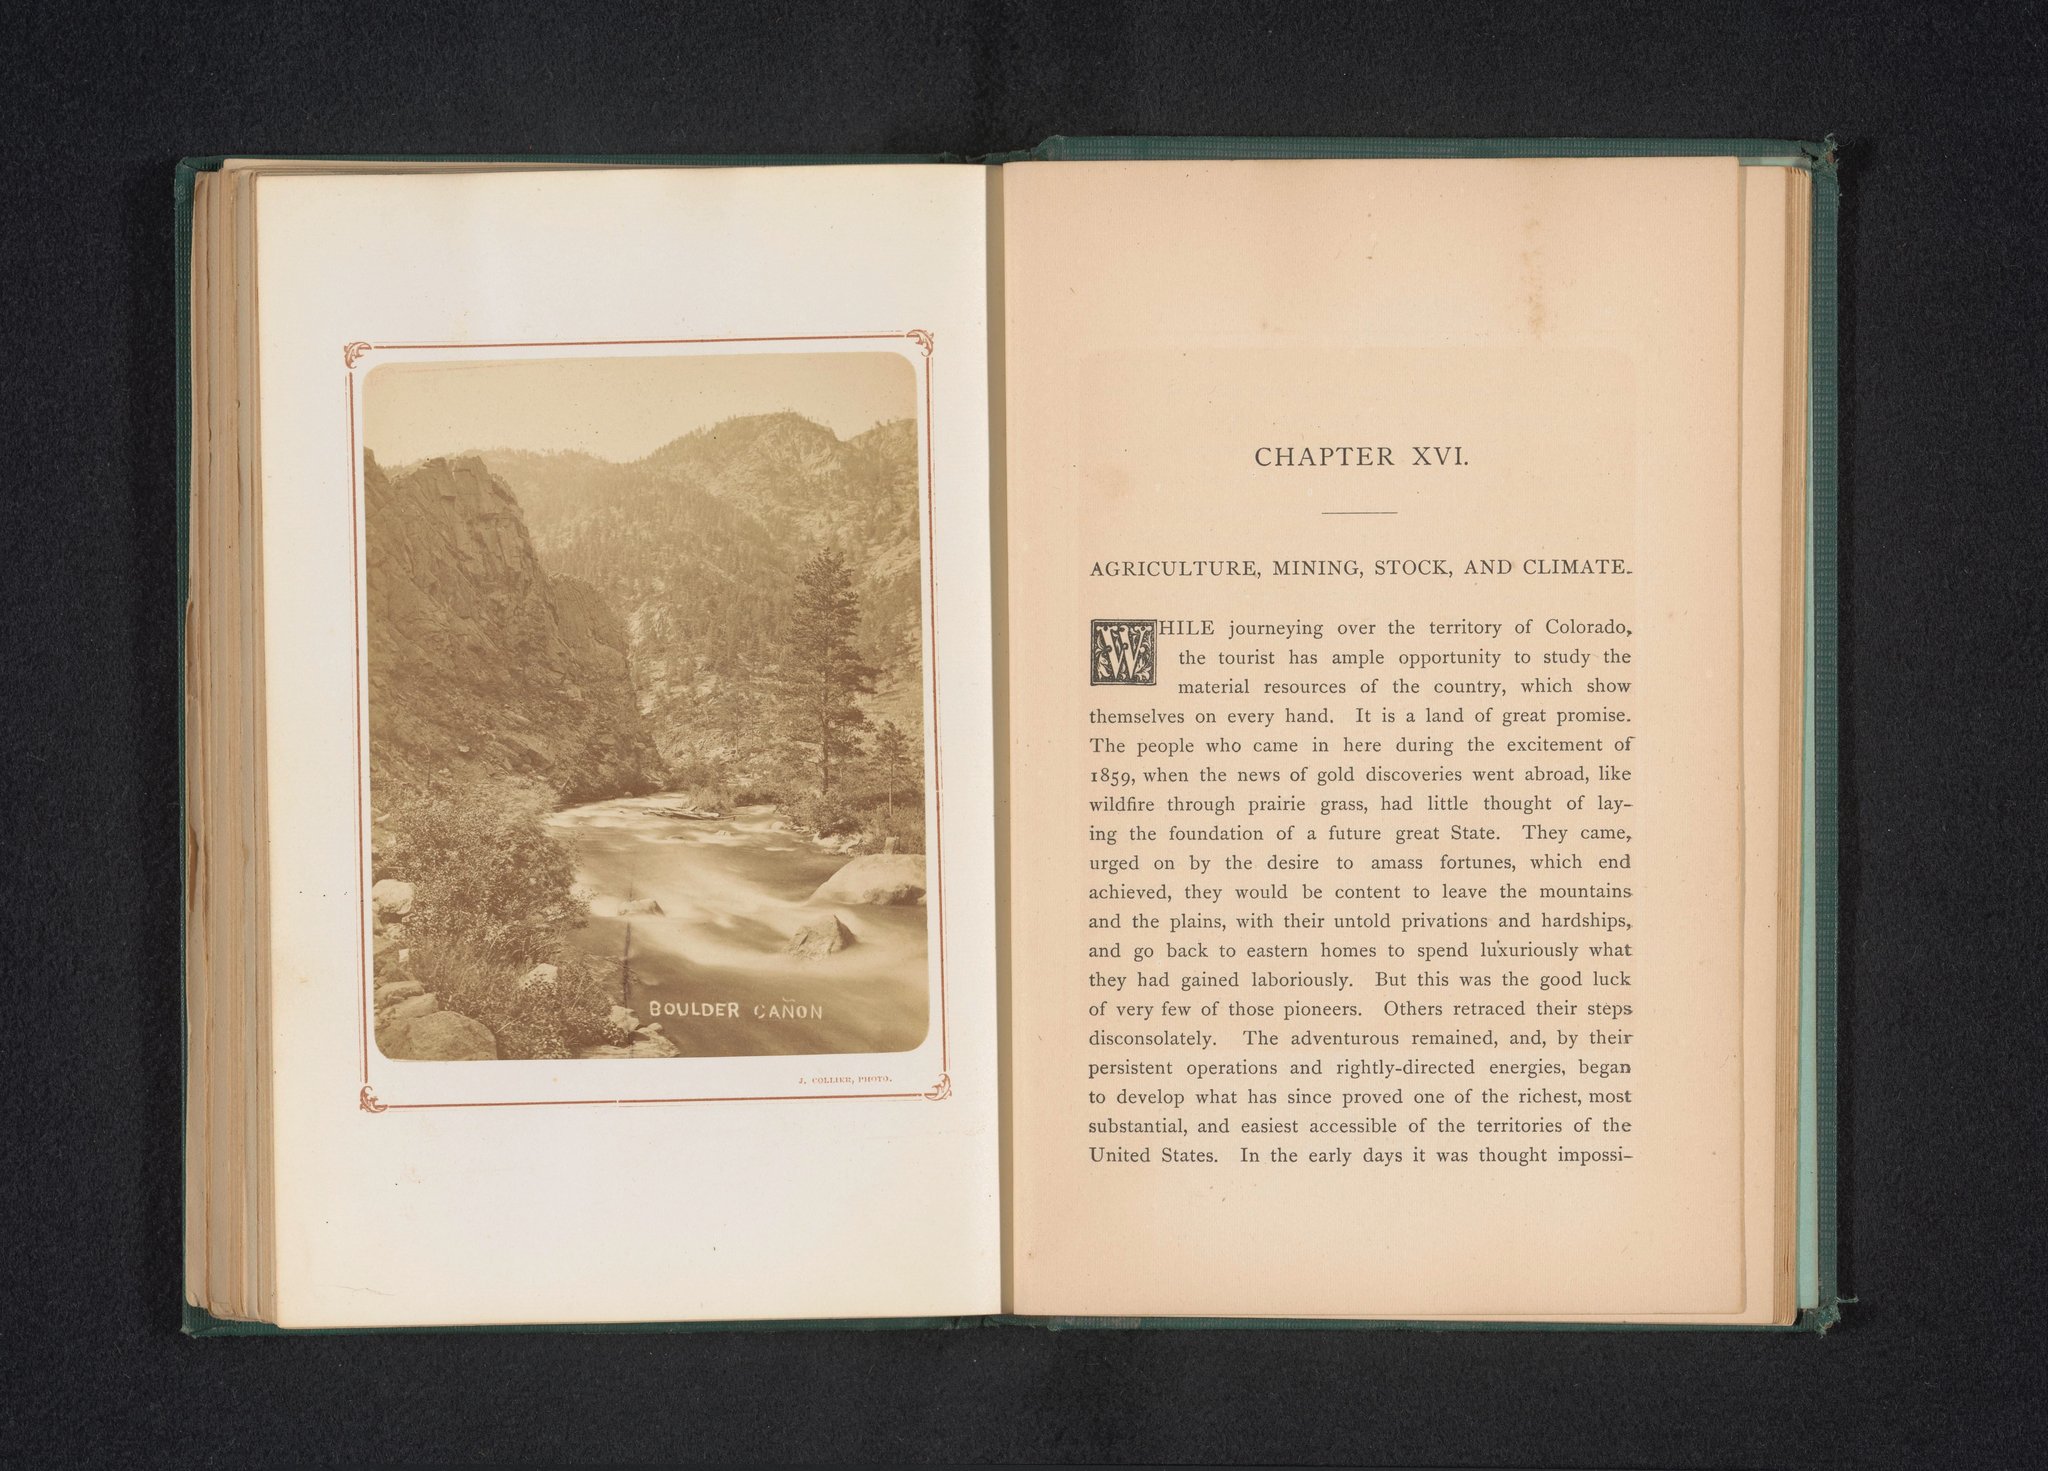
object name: photograph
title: Landschap bij Boulder, Colorado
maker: joseph collier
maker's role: fotograaf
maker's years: 1836-1910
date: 1869-1874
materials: photographic support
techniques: albumen print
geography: boulder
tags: river, mountains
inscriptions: inscription: ‘Boulder, cañon’